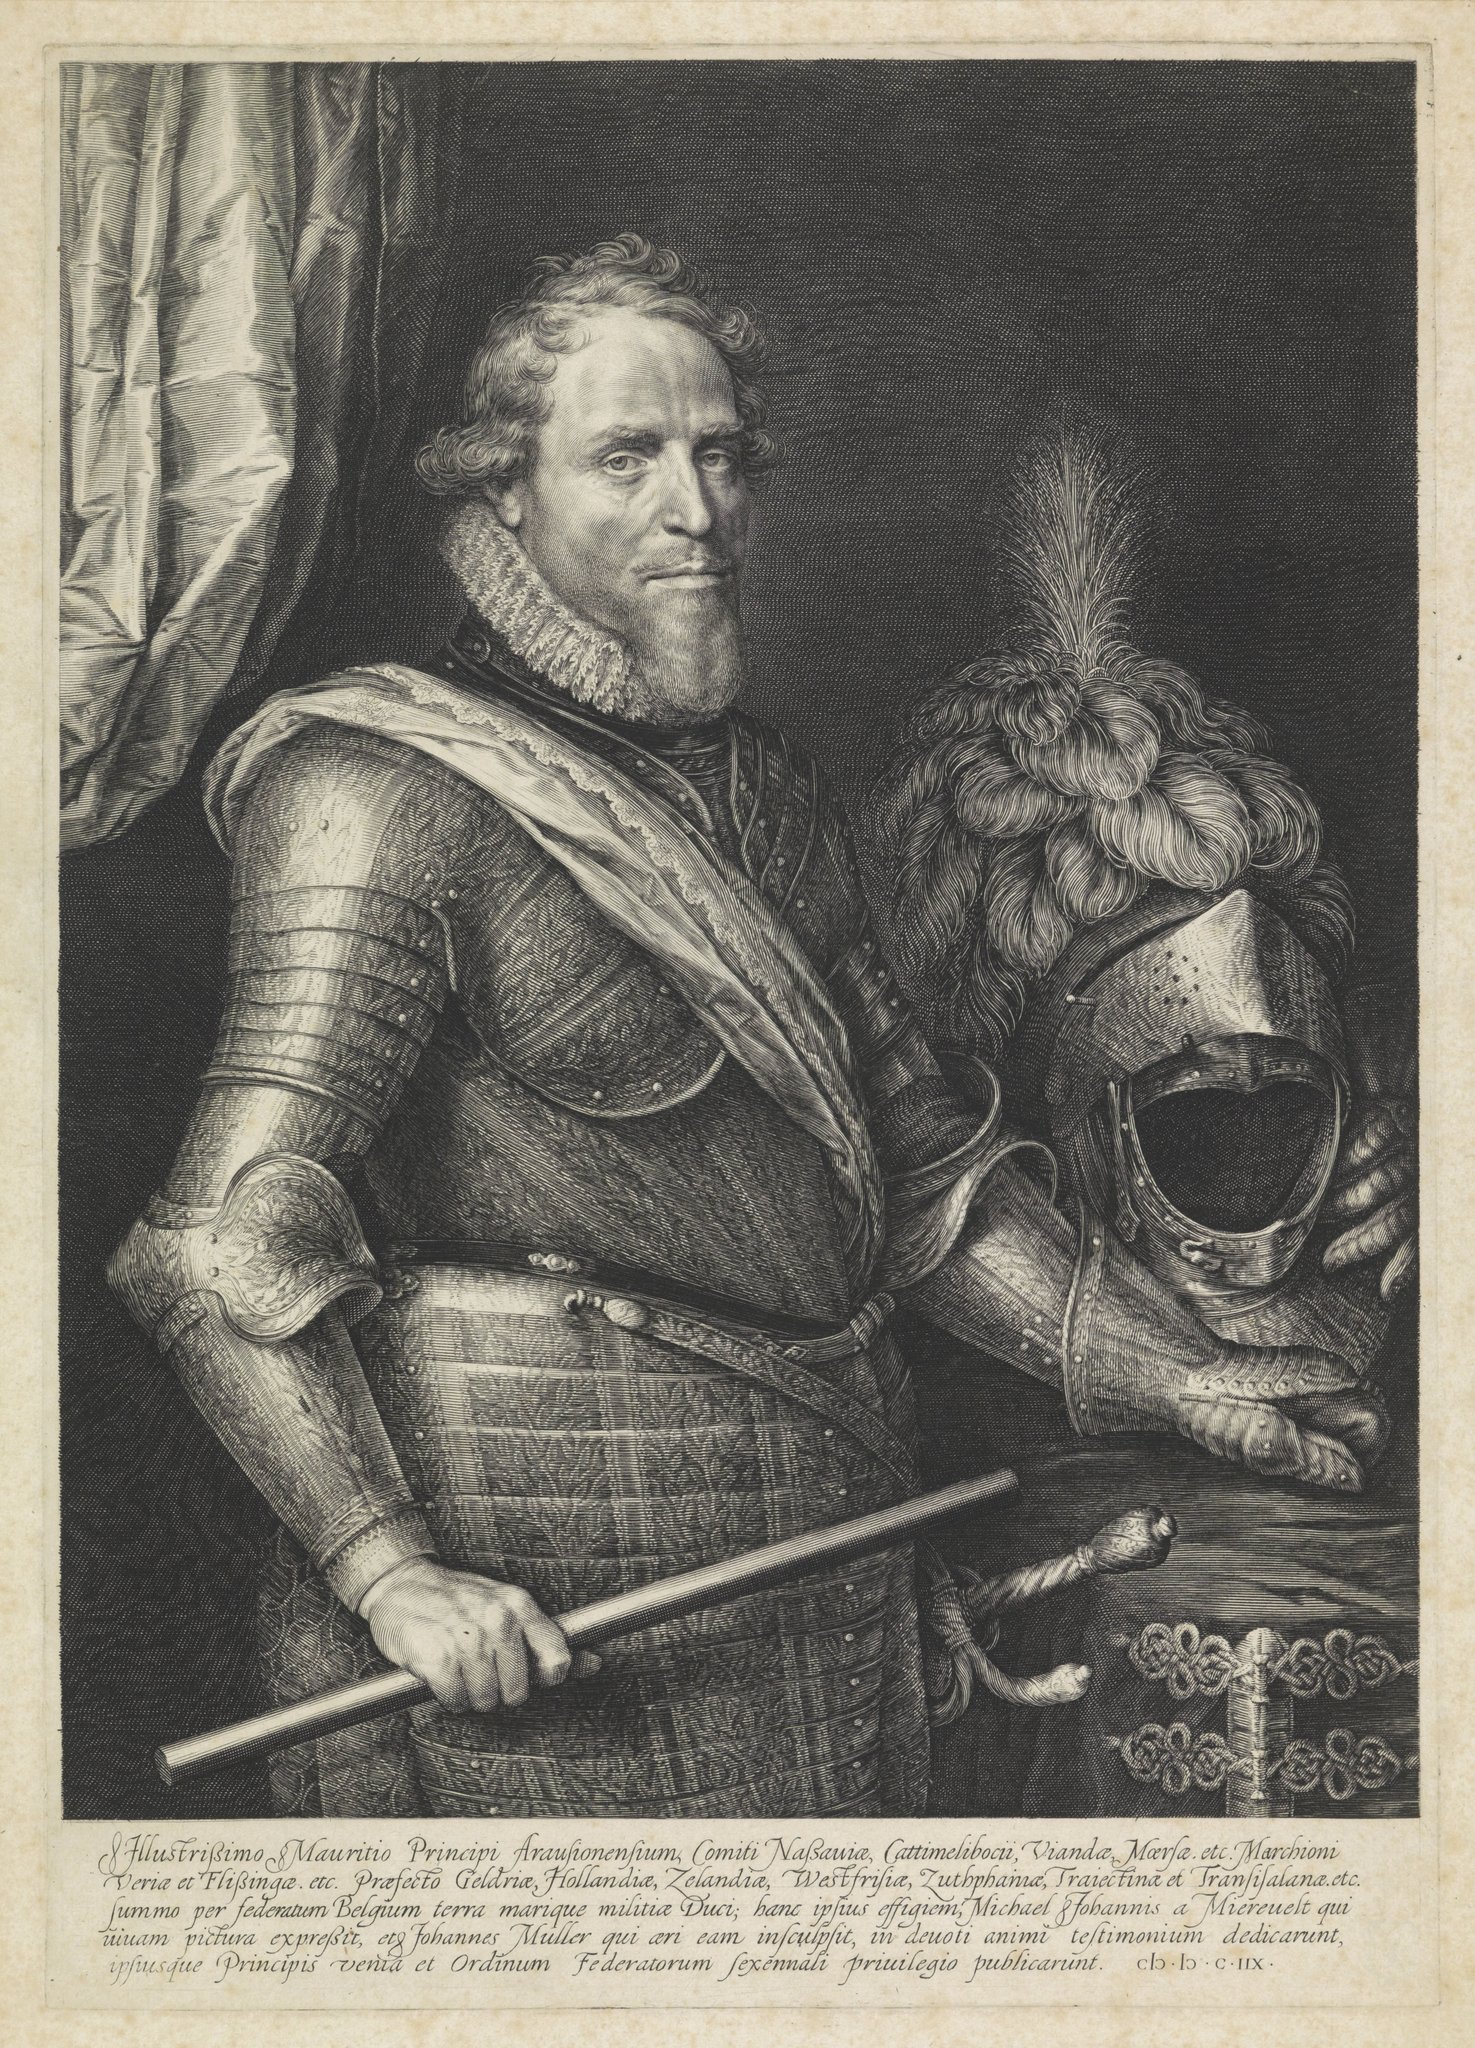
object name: print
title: Portret van Maurits, prins van Oranje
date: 1608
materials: paper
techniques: engraving, etching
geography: amsterdam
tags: maurice (prince of orange)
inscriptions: collector's mark: Lugt 963, collector's mark: Lugt 2228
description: Portret van Maurits. Hij staat naast een tafel met daarop de helm van zijn harnas. Hij houdt een commandostaf in de hand. In de ondermarge vijf regels Latijnse tekst.